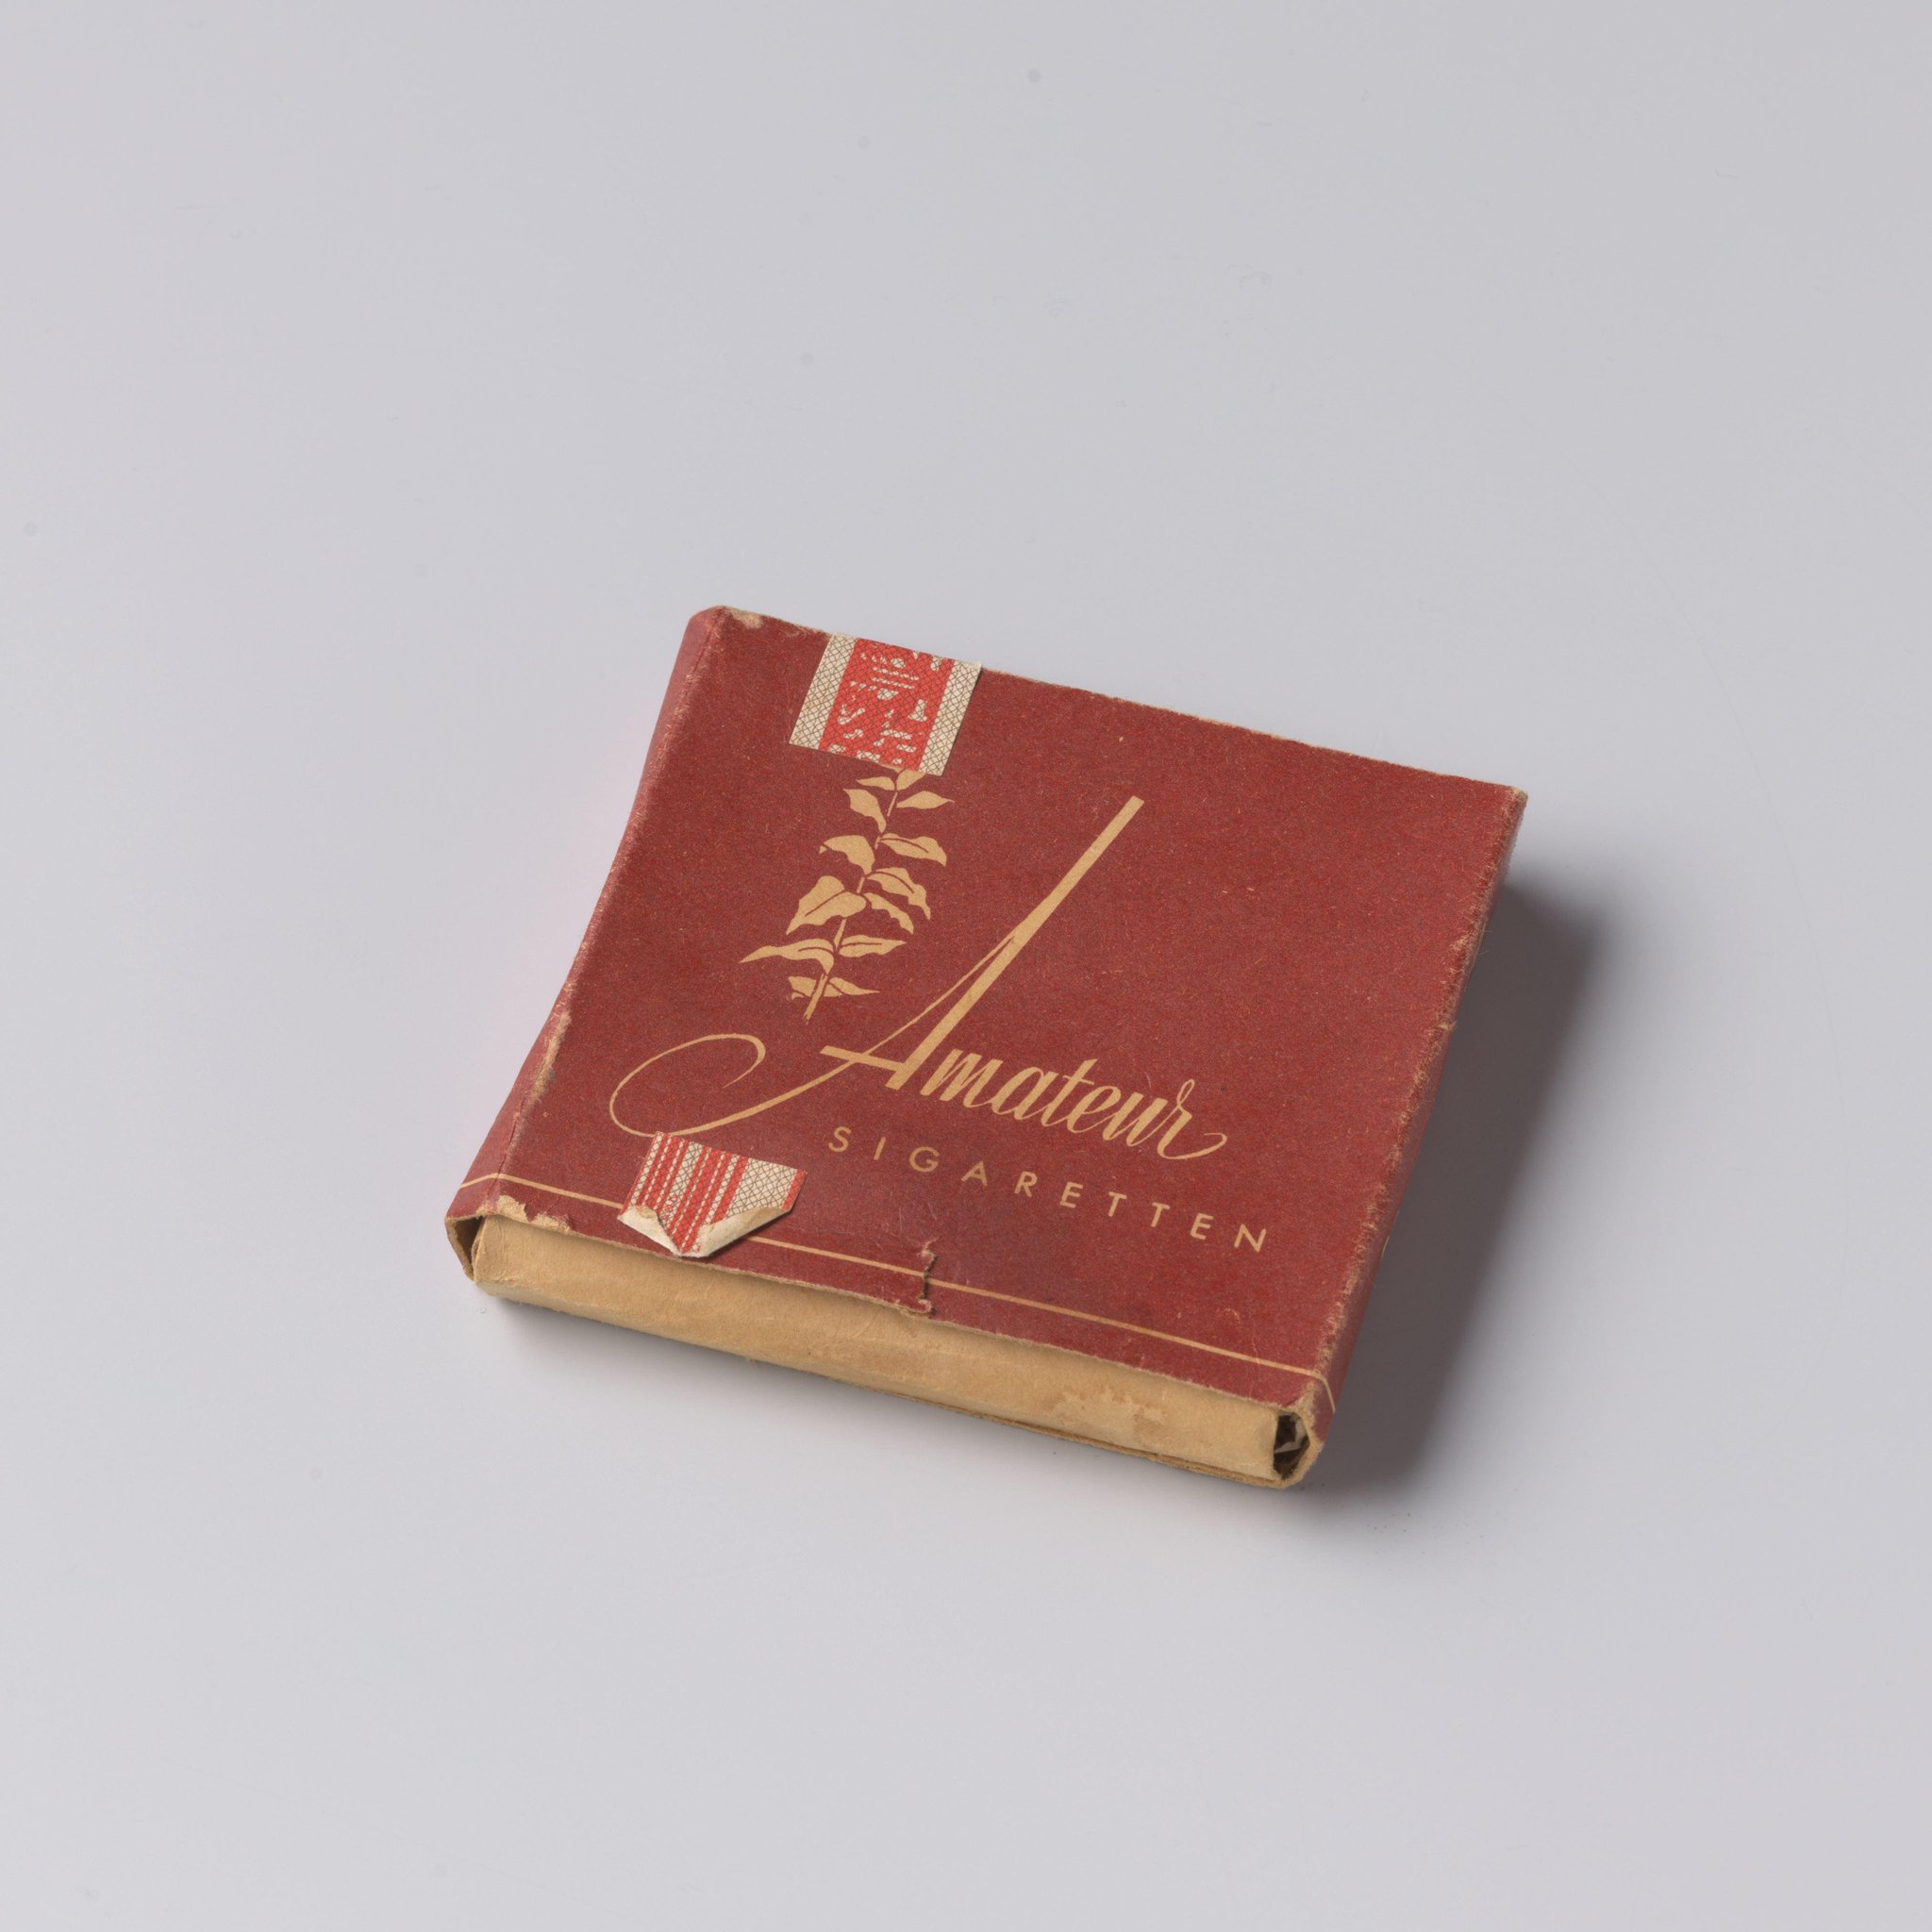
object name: sigaret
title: Amateur sigaretten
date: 1940-1945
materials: cardboard, paper, metal, plant material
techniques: printing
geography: waddinxveen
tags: netherlands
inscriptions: inscription: ‘Amateur / sigaretten’, inscription: ‘Louis Dobbelmann n.v. / Waddinxveen’, inscription: ‘De sigaretten zijn do... / vervaardigd uit inlandse.. / die ons ter verwerking... / amateurtelers ter besc.../ is gesteld.’, signature: ‘20 ct. / + opc. 4 ct.’, inscription: ‘20 / amateur / sigaretten’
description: Rechthoekig doosje met 14 sigaretten. Voorzijde: opschrift en tabakplant. Keerzijde: opschrift in kader en m.o.: signatuur. Kleur: donkerbruin en beige. Verticaal over doos een plakstrook met golfmotief in de kleuren wit/bruin/rood met daarop in zwart: opschrift en signatuur.